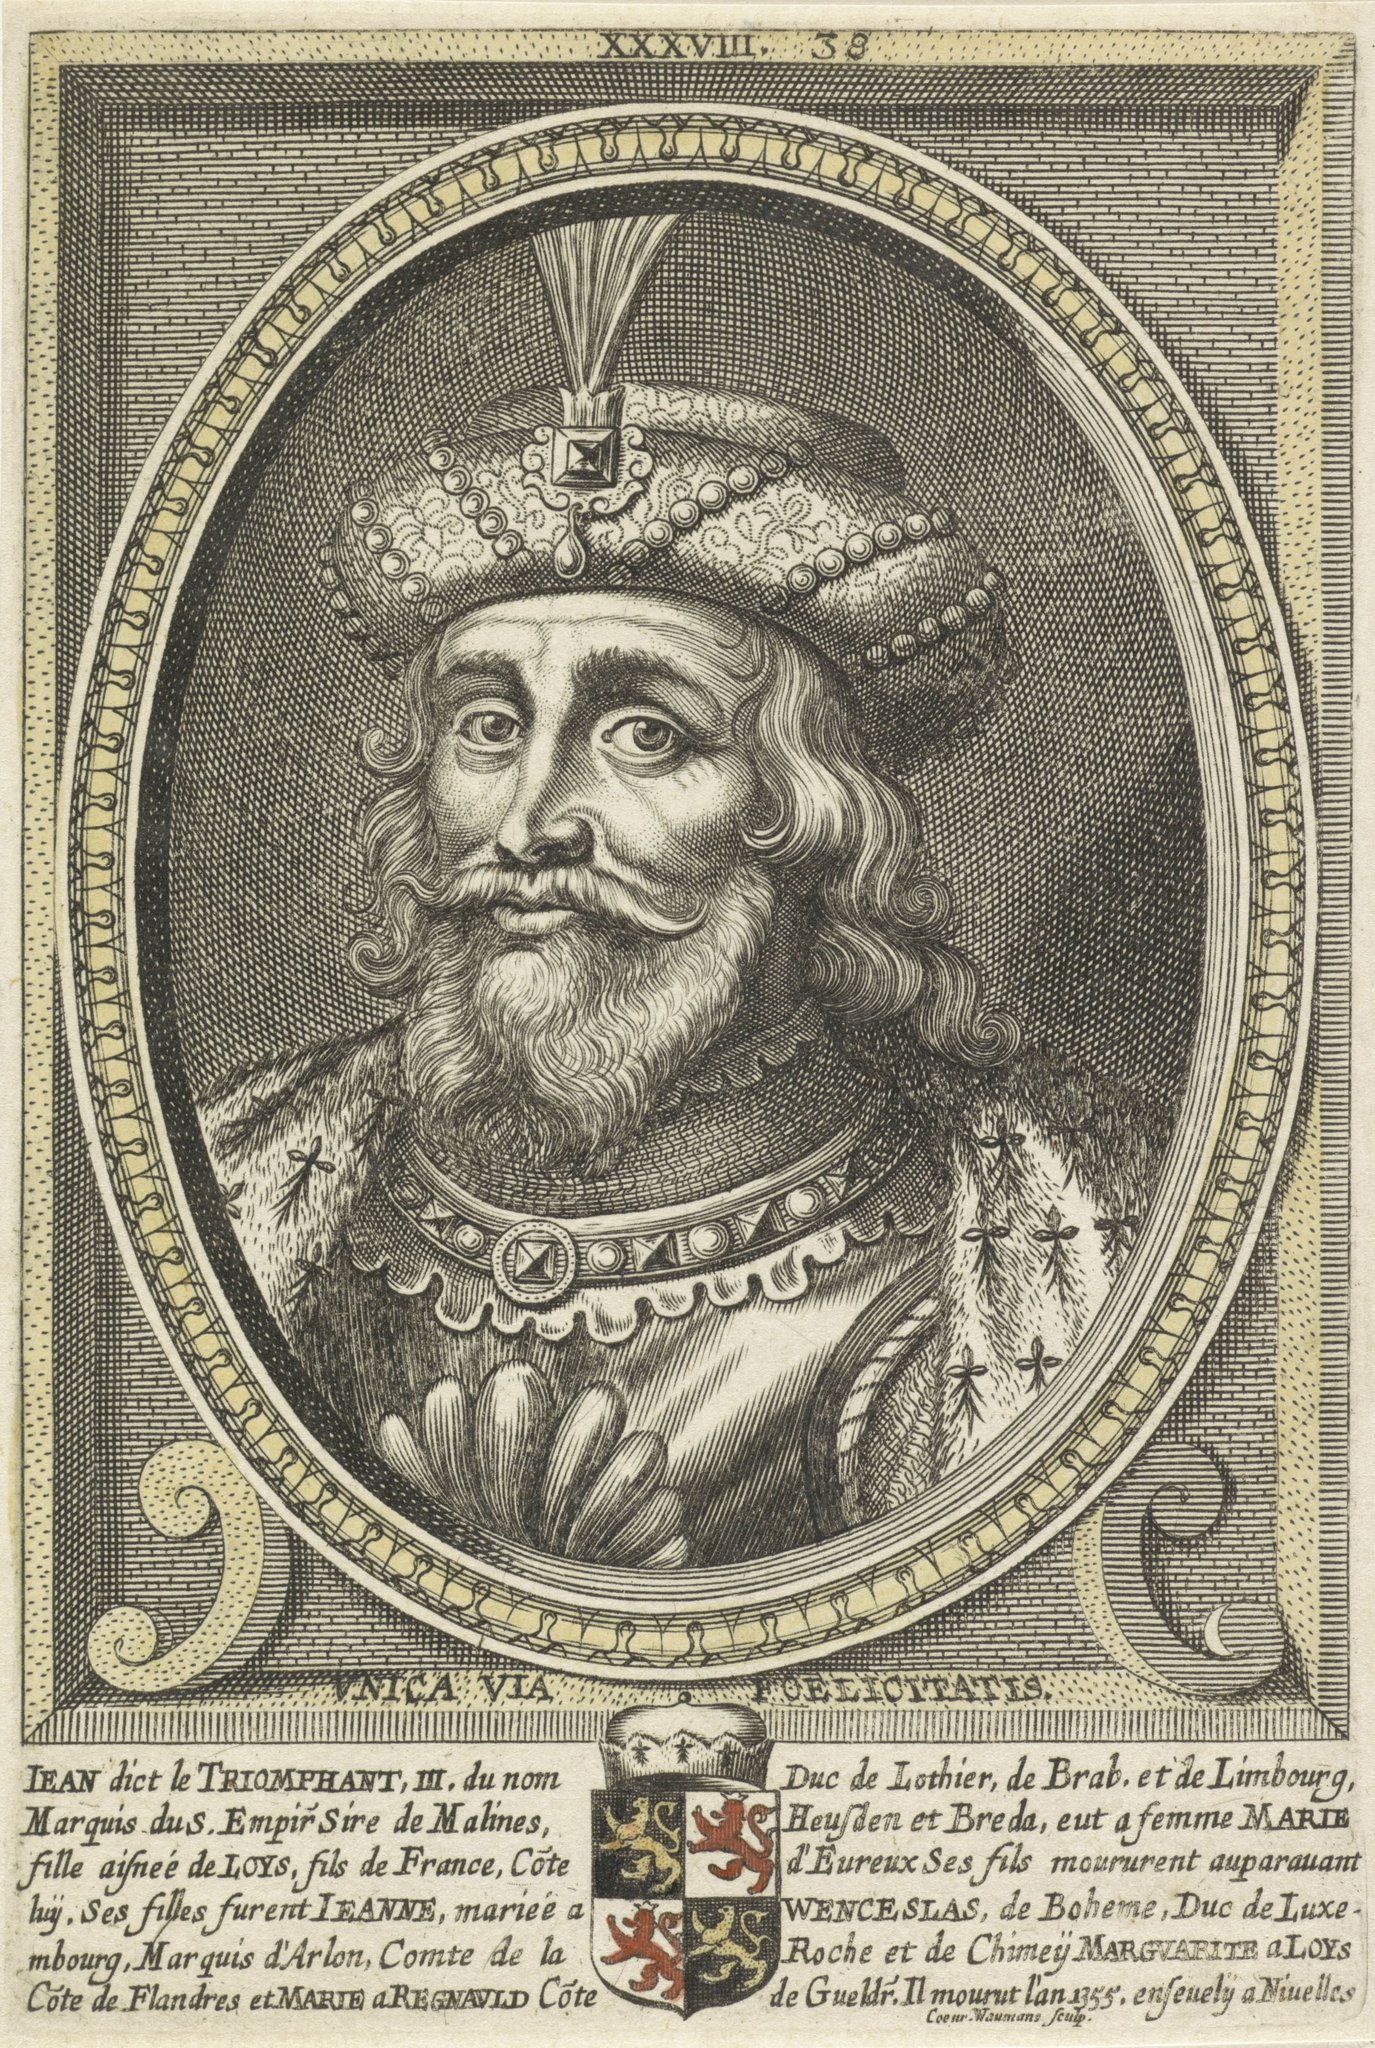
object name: print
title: Portret van Jan III, hertog van Brabant en Lotharingen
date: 1662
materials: paper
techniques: engraving, hand coloring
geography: antwerp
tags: brussels, armorial bearing, heraldry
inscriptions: collector's mark: Lugt 2228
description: Prent gebruikt in: Meyssens, C. Les pourtraits des souverains princes et comtes de Hollande. Antwerpen: Martinus van den Enden, 1662. Op de frontispiece wordt Richard Collin specifiek genoemd als graveur van de wapenschilden op de prenten in deze uitgave.